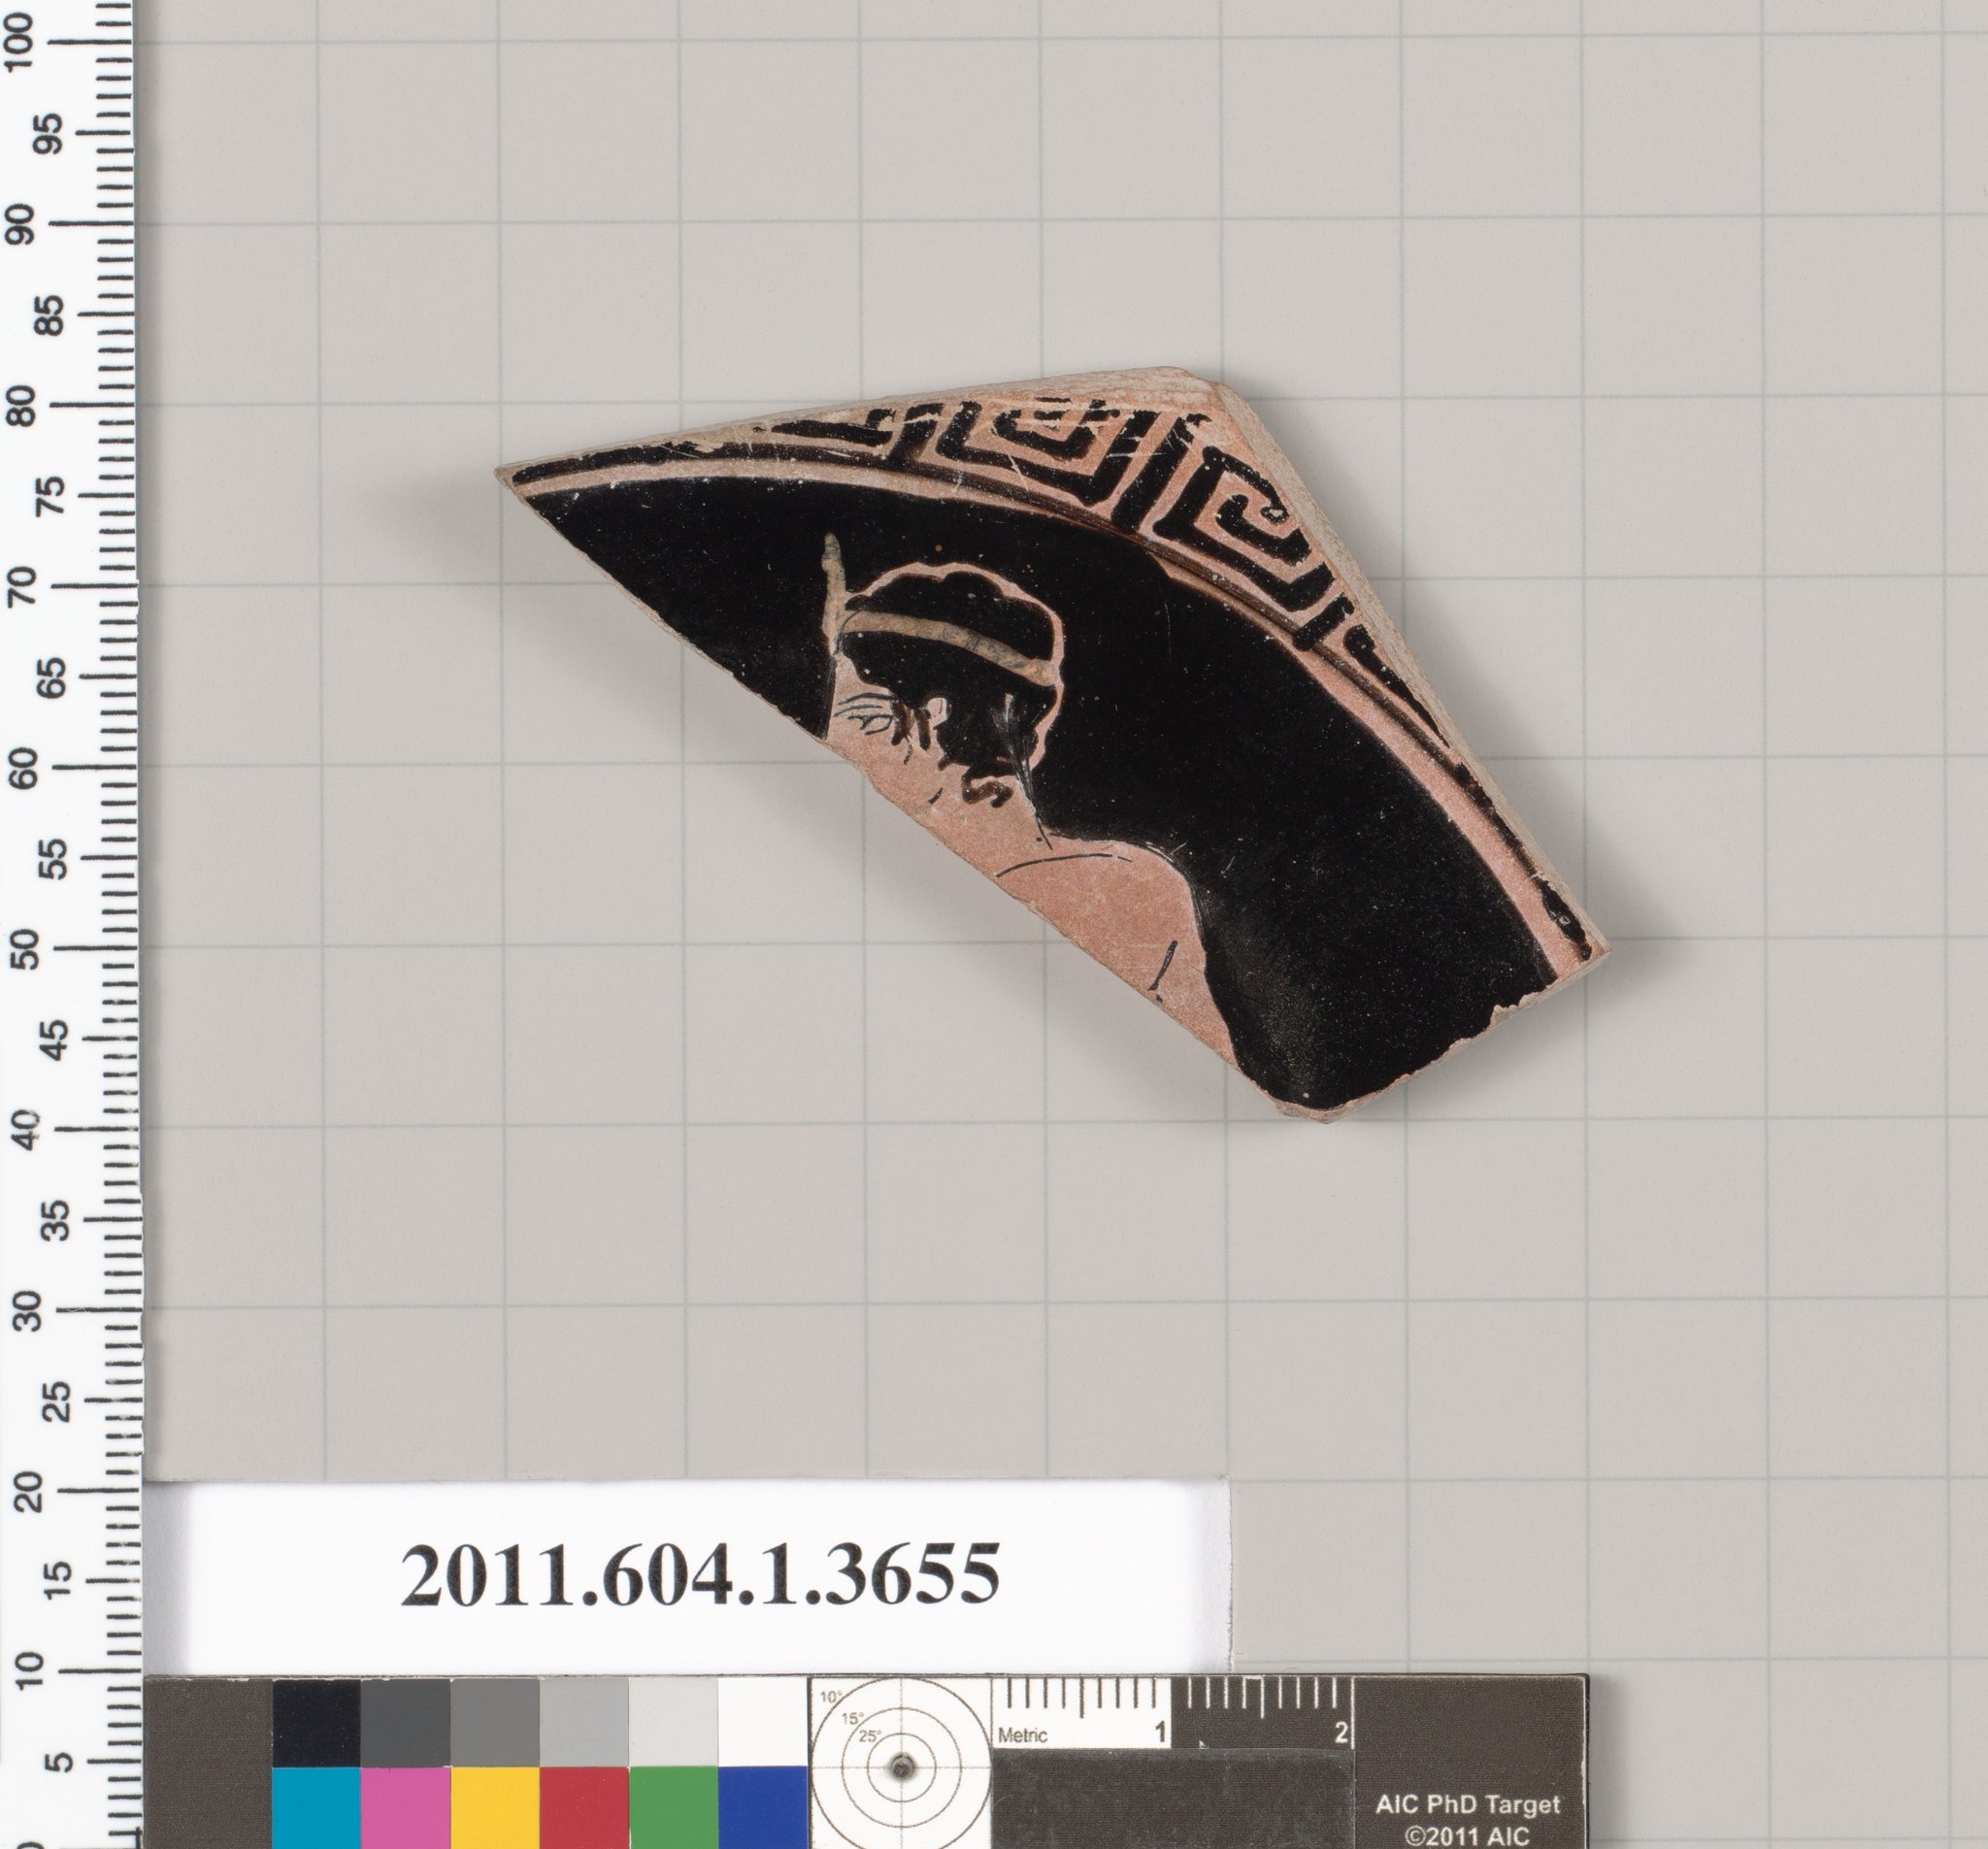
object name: kylix fragment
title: Terracotta fragment of a kylix (drinking cup)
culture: greek, attic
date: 470-450 BCE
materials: terracotta